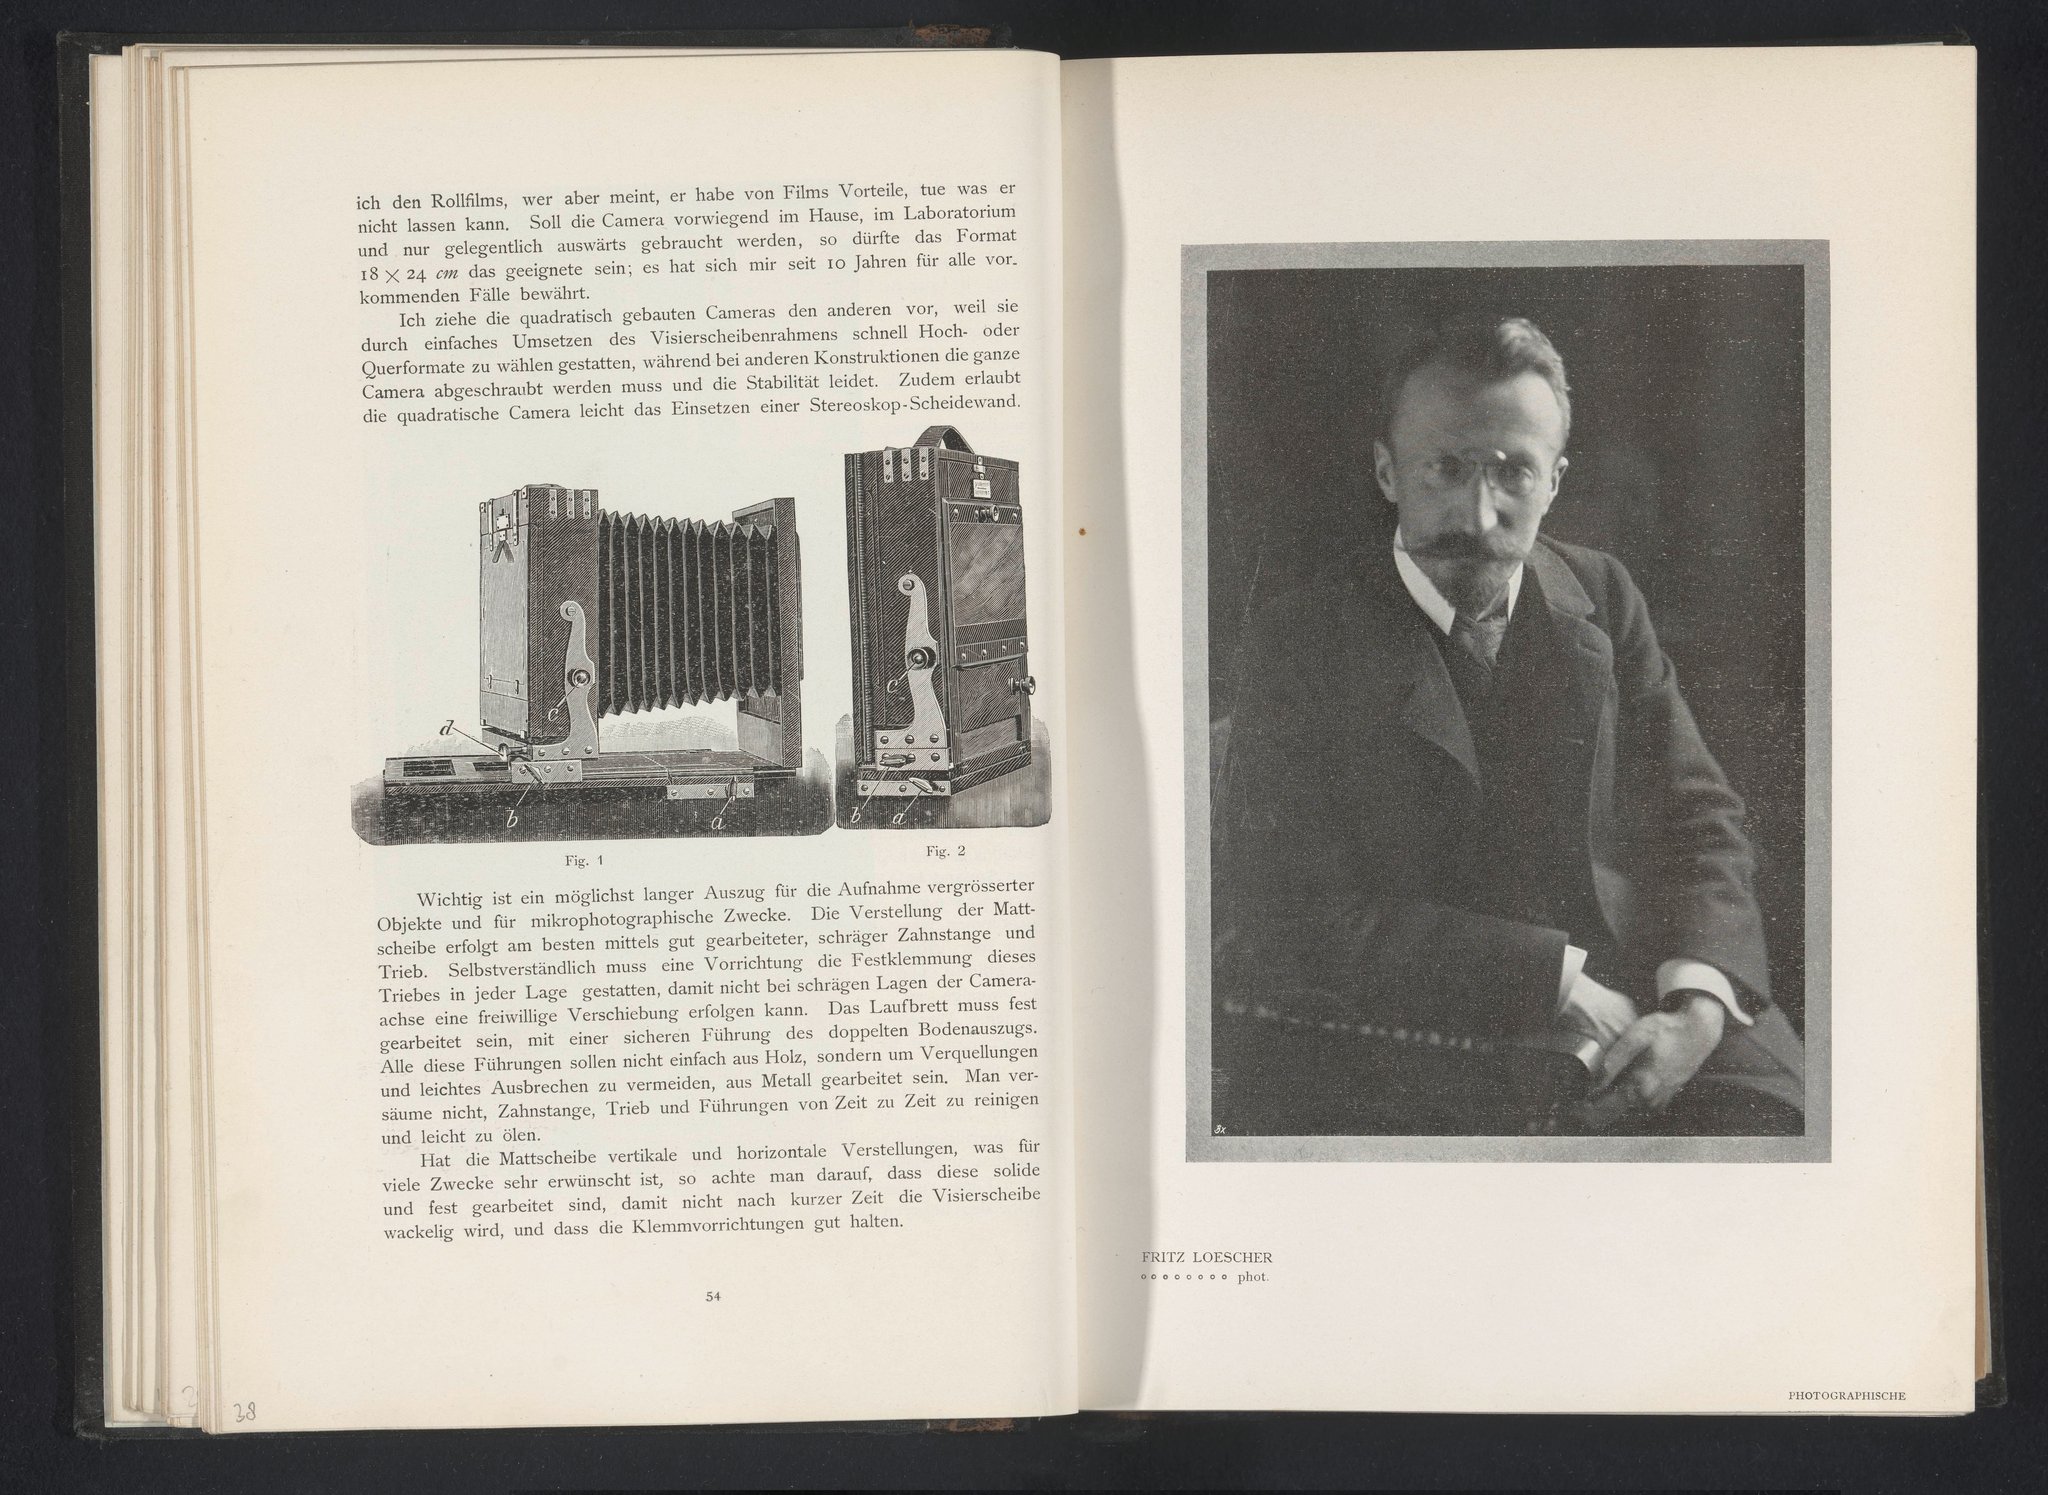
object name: page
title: Veldcamera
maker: Anonymous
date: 1898-1903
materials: paper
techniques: autotype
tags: camera ~ photography